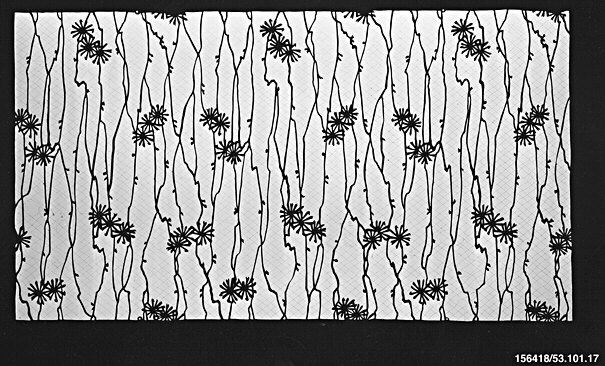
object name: stencil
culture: japanese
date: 1615-1868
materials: paper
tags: flowers